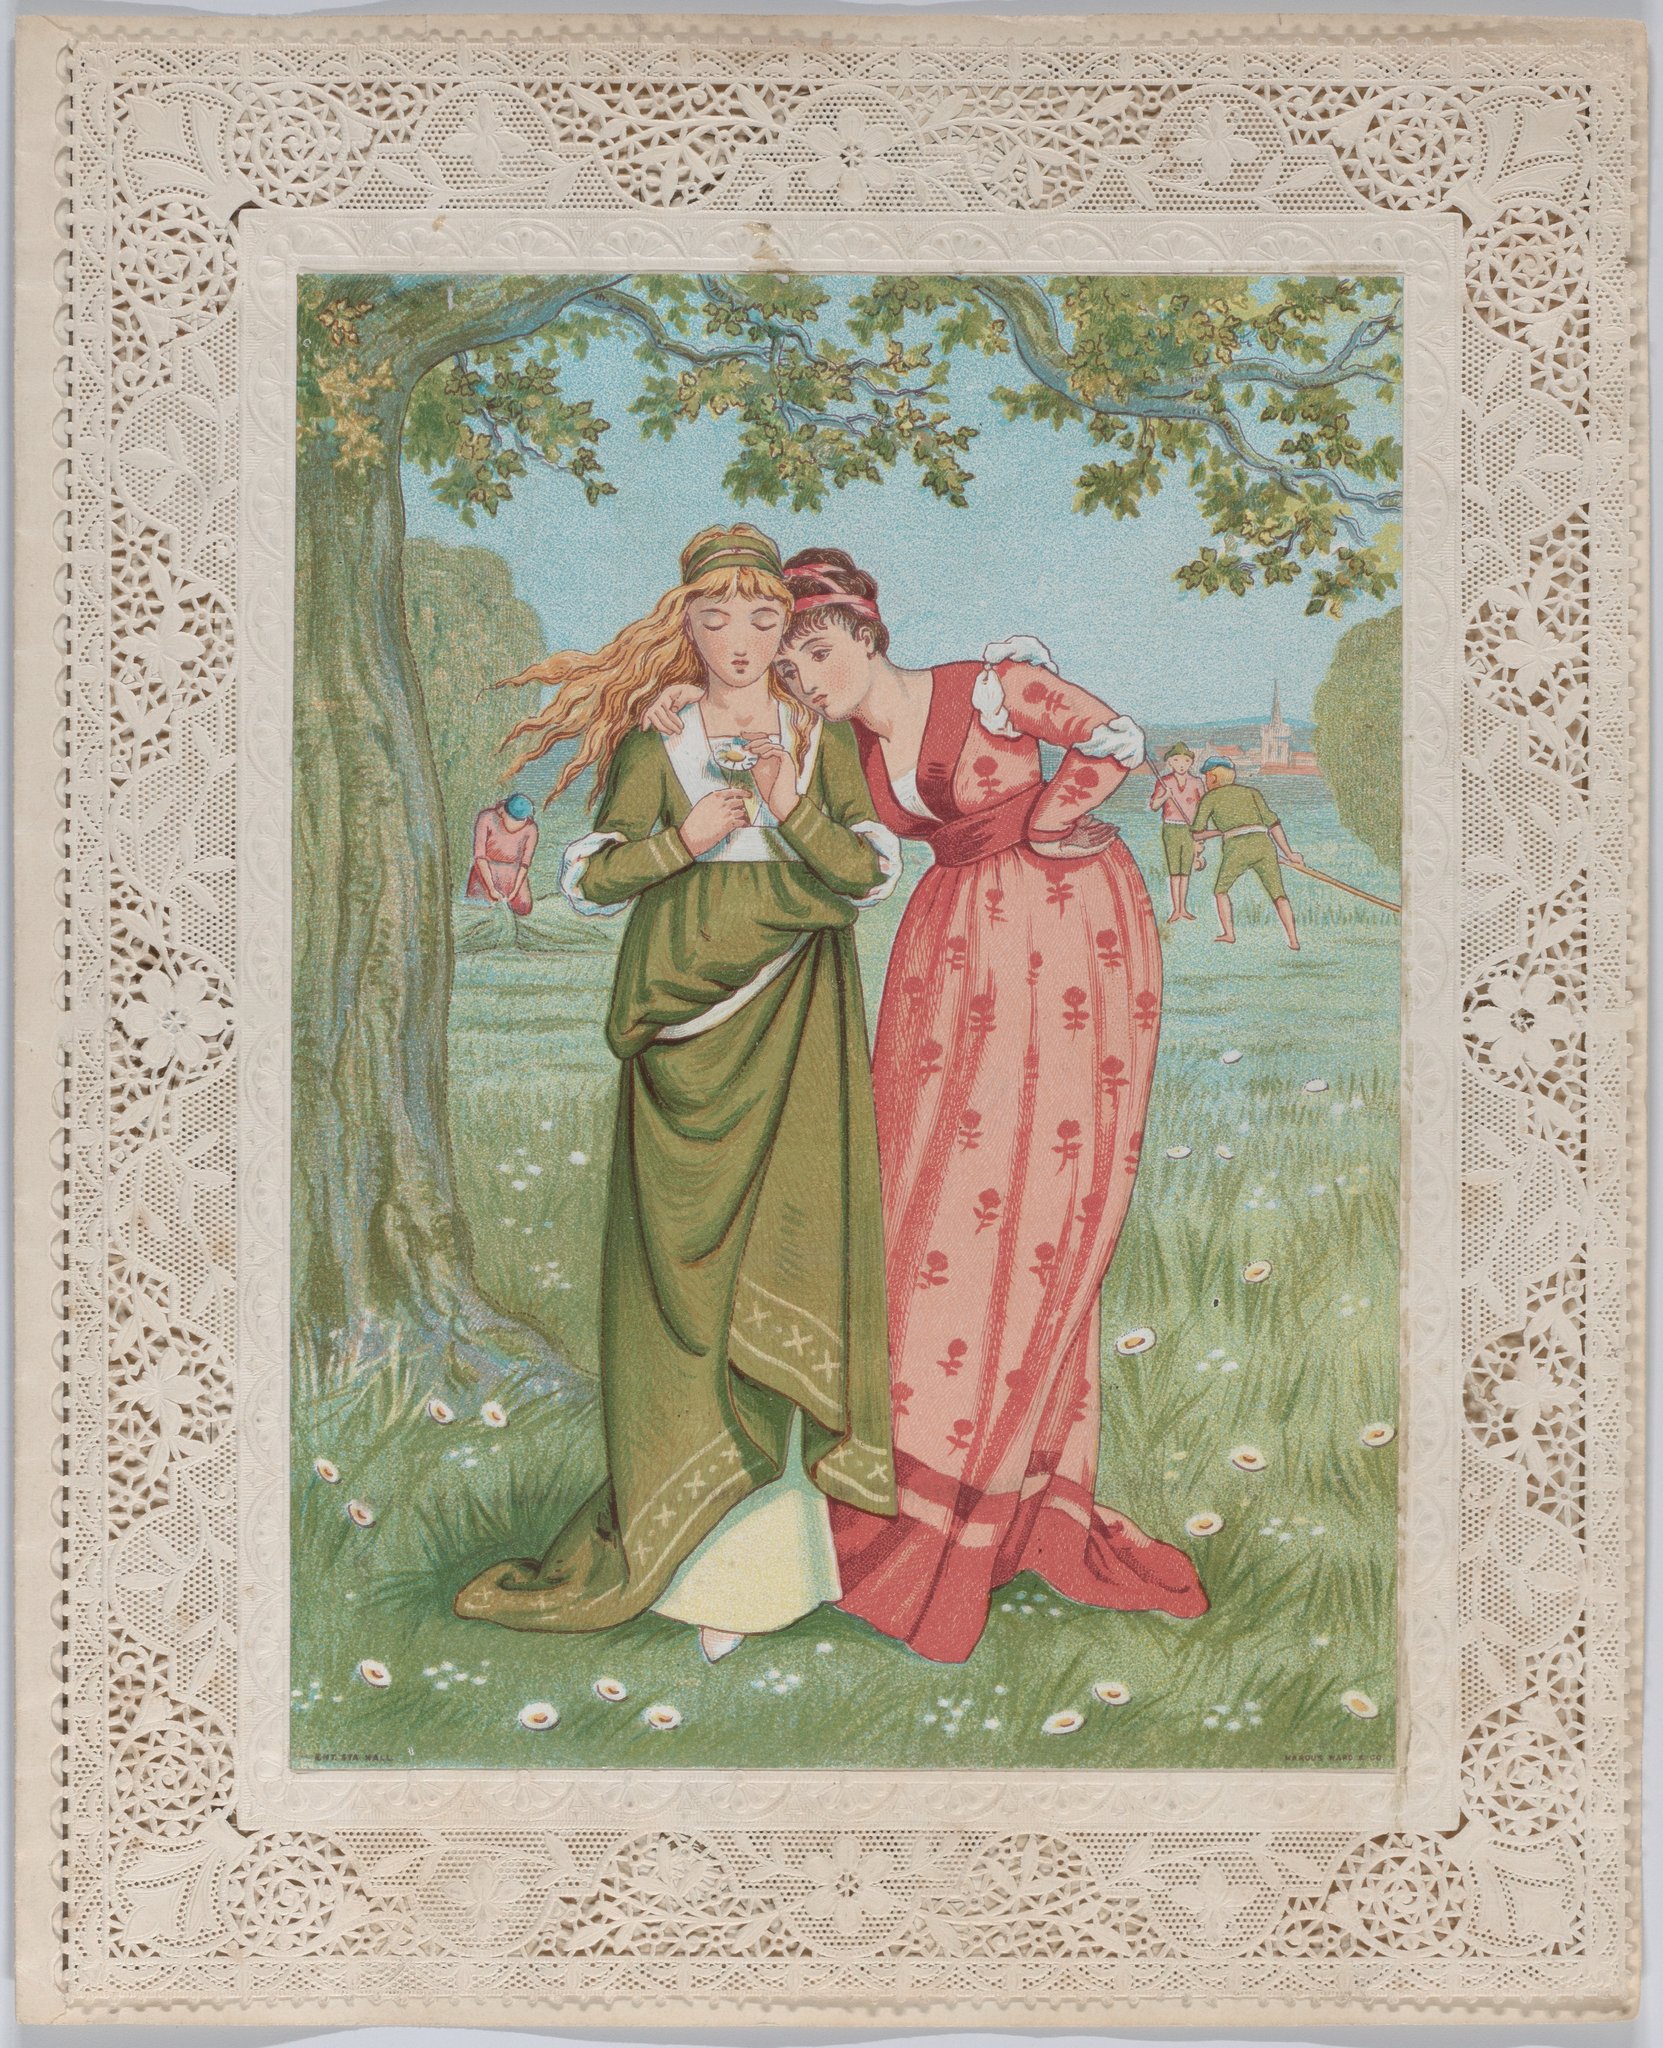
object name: valentine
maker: kate greenaway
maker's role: artist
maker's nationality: british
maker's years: 1846-1901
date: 1876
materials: gold, lace, paper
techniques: chromolithography, gilding, lithograph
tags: women